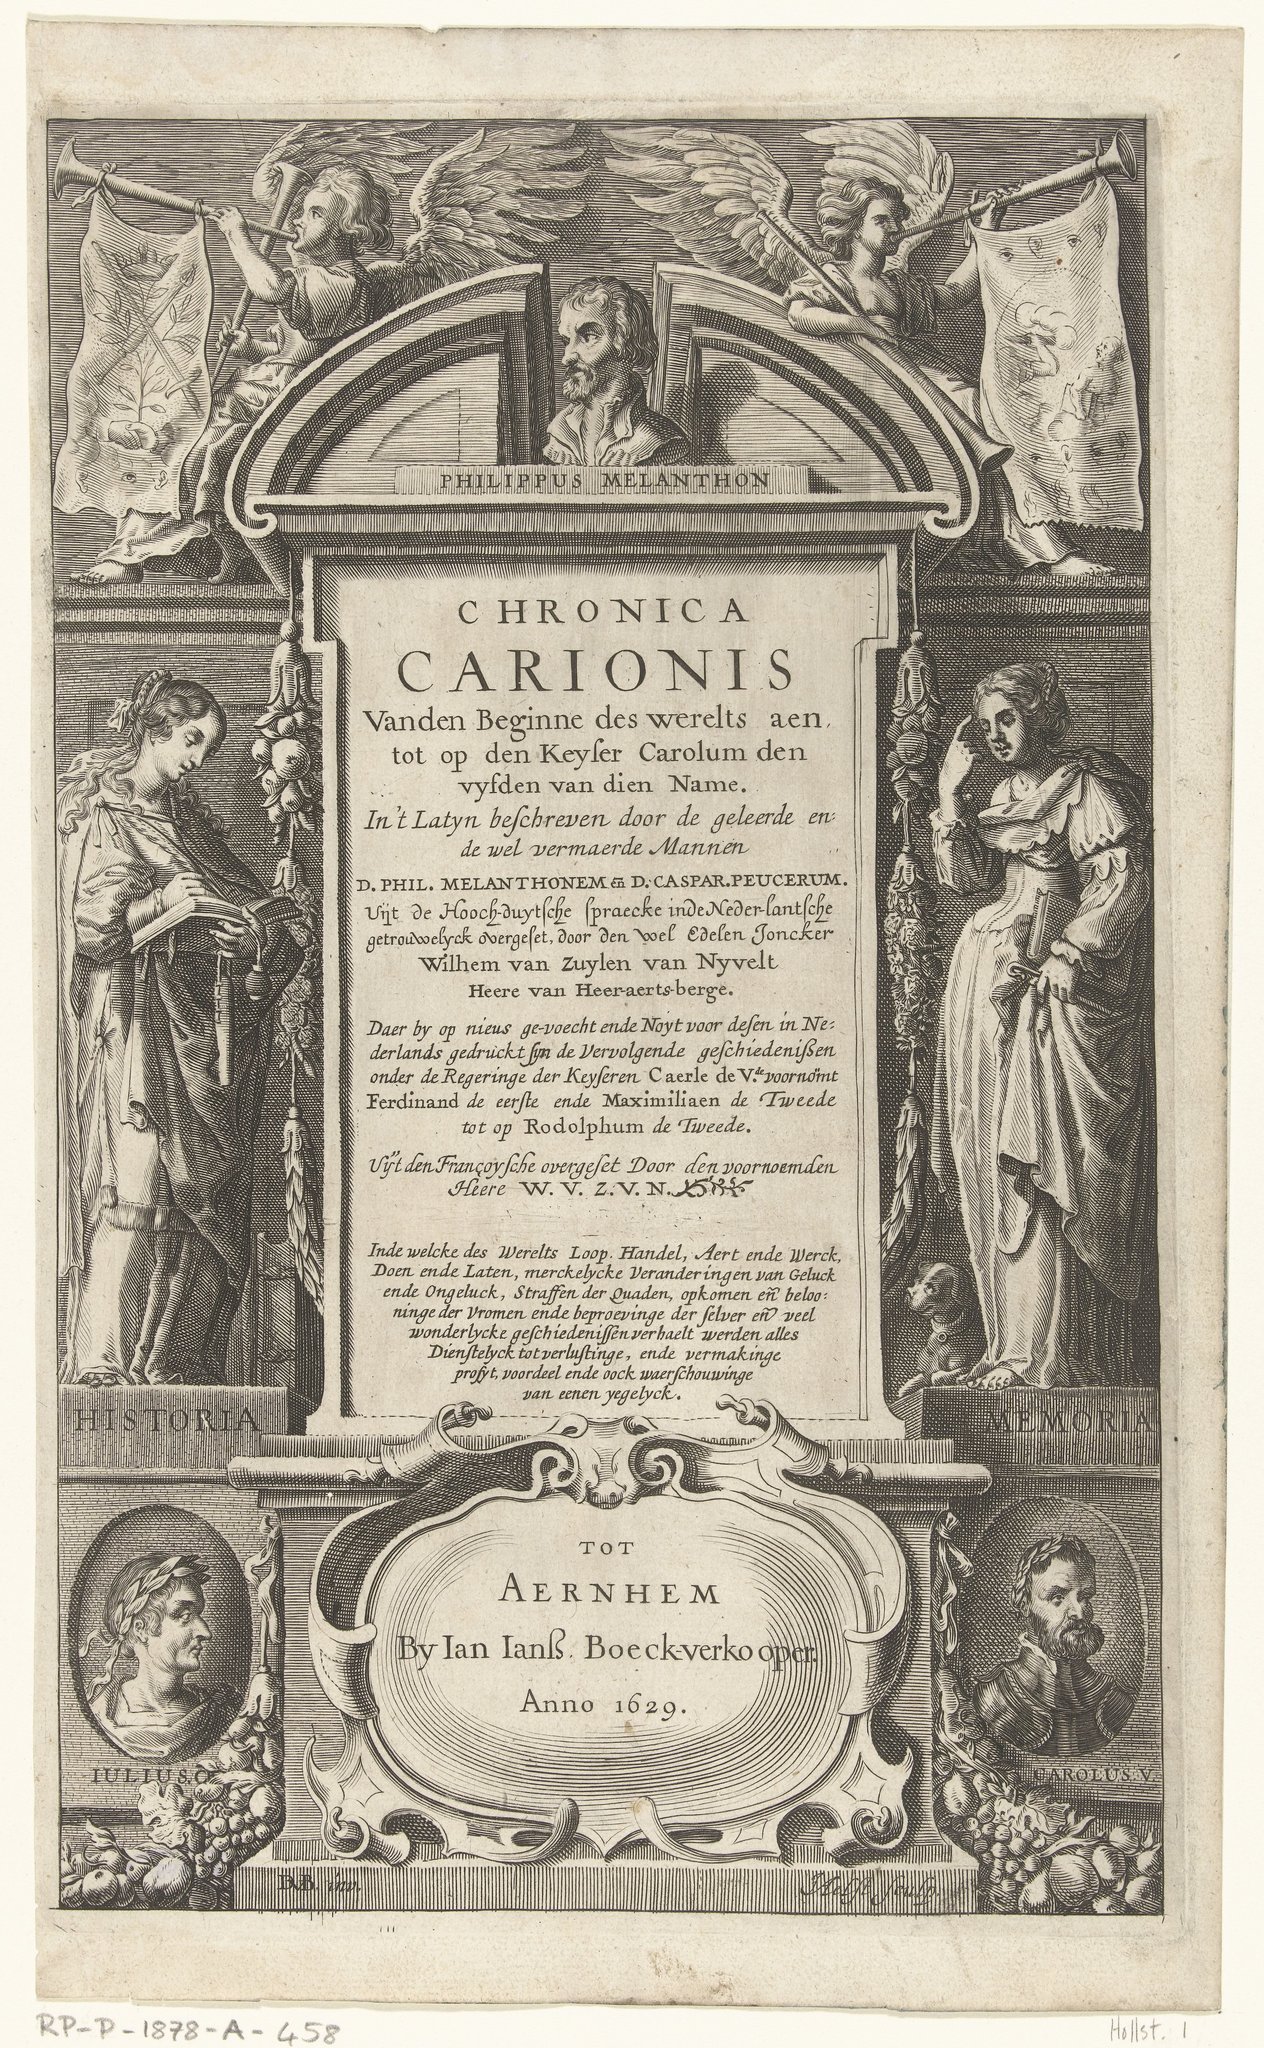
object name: titelblad, titelpagina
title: Chronica Carionis vanden beginne des werelts aen tot op den Keyser Carolum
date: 1629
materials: paper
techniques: engraving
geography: arnhem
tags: rome, ghent, charles v (holy roman emperor and king of spain), historical persons, memory; 'memoria' (ripa), 'historia'; 'historia' (ripa)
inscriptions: collector's mark: Lugt 2228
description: Een plaquette in een architecturale omlijsting vermeldt de titel van het boek. Op de plaquette staat een portretbuste van P. Melanchthon. Aan weerszijden staan de allegorische figuren Historia en Memoria op stenen sokkels. Op de sokkels medaillons met de portretten van Julius Caesar en keizer Karel V.